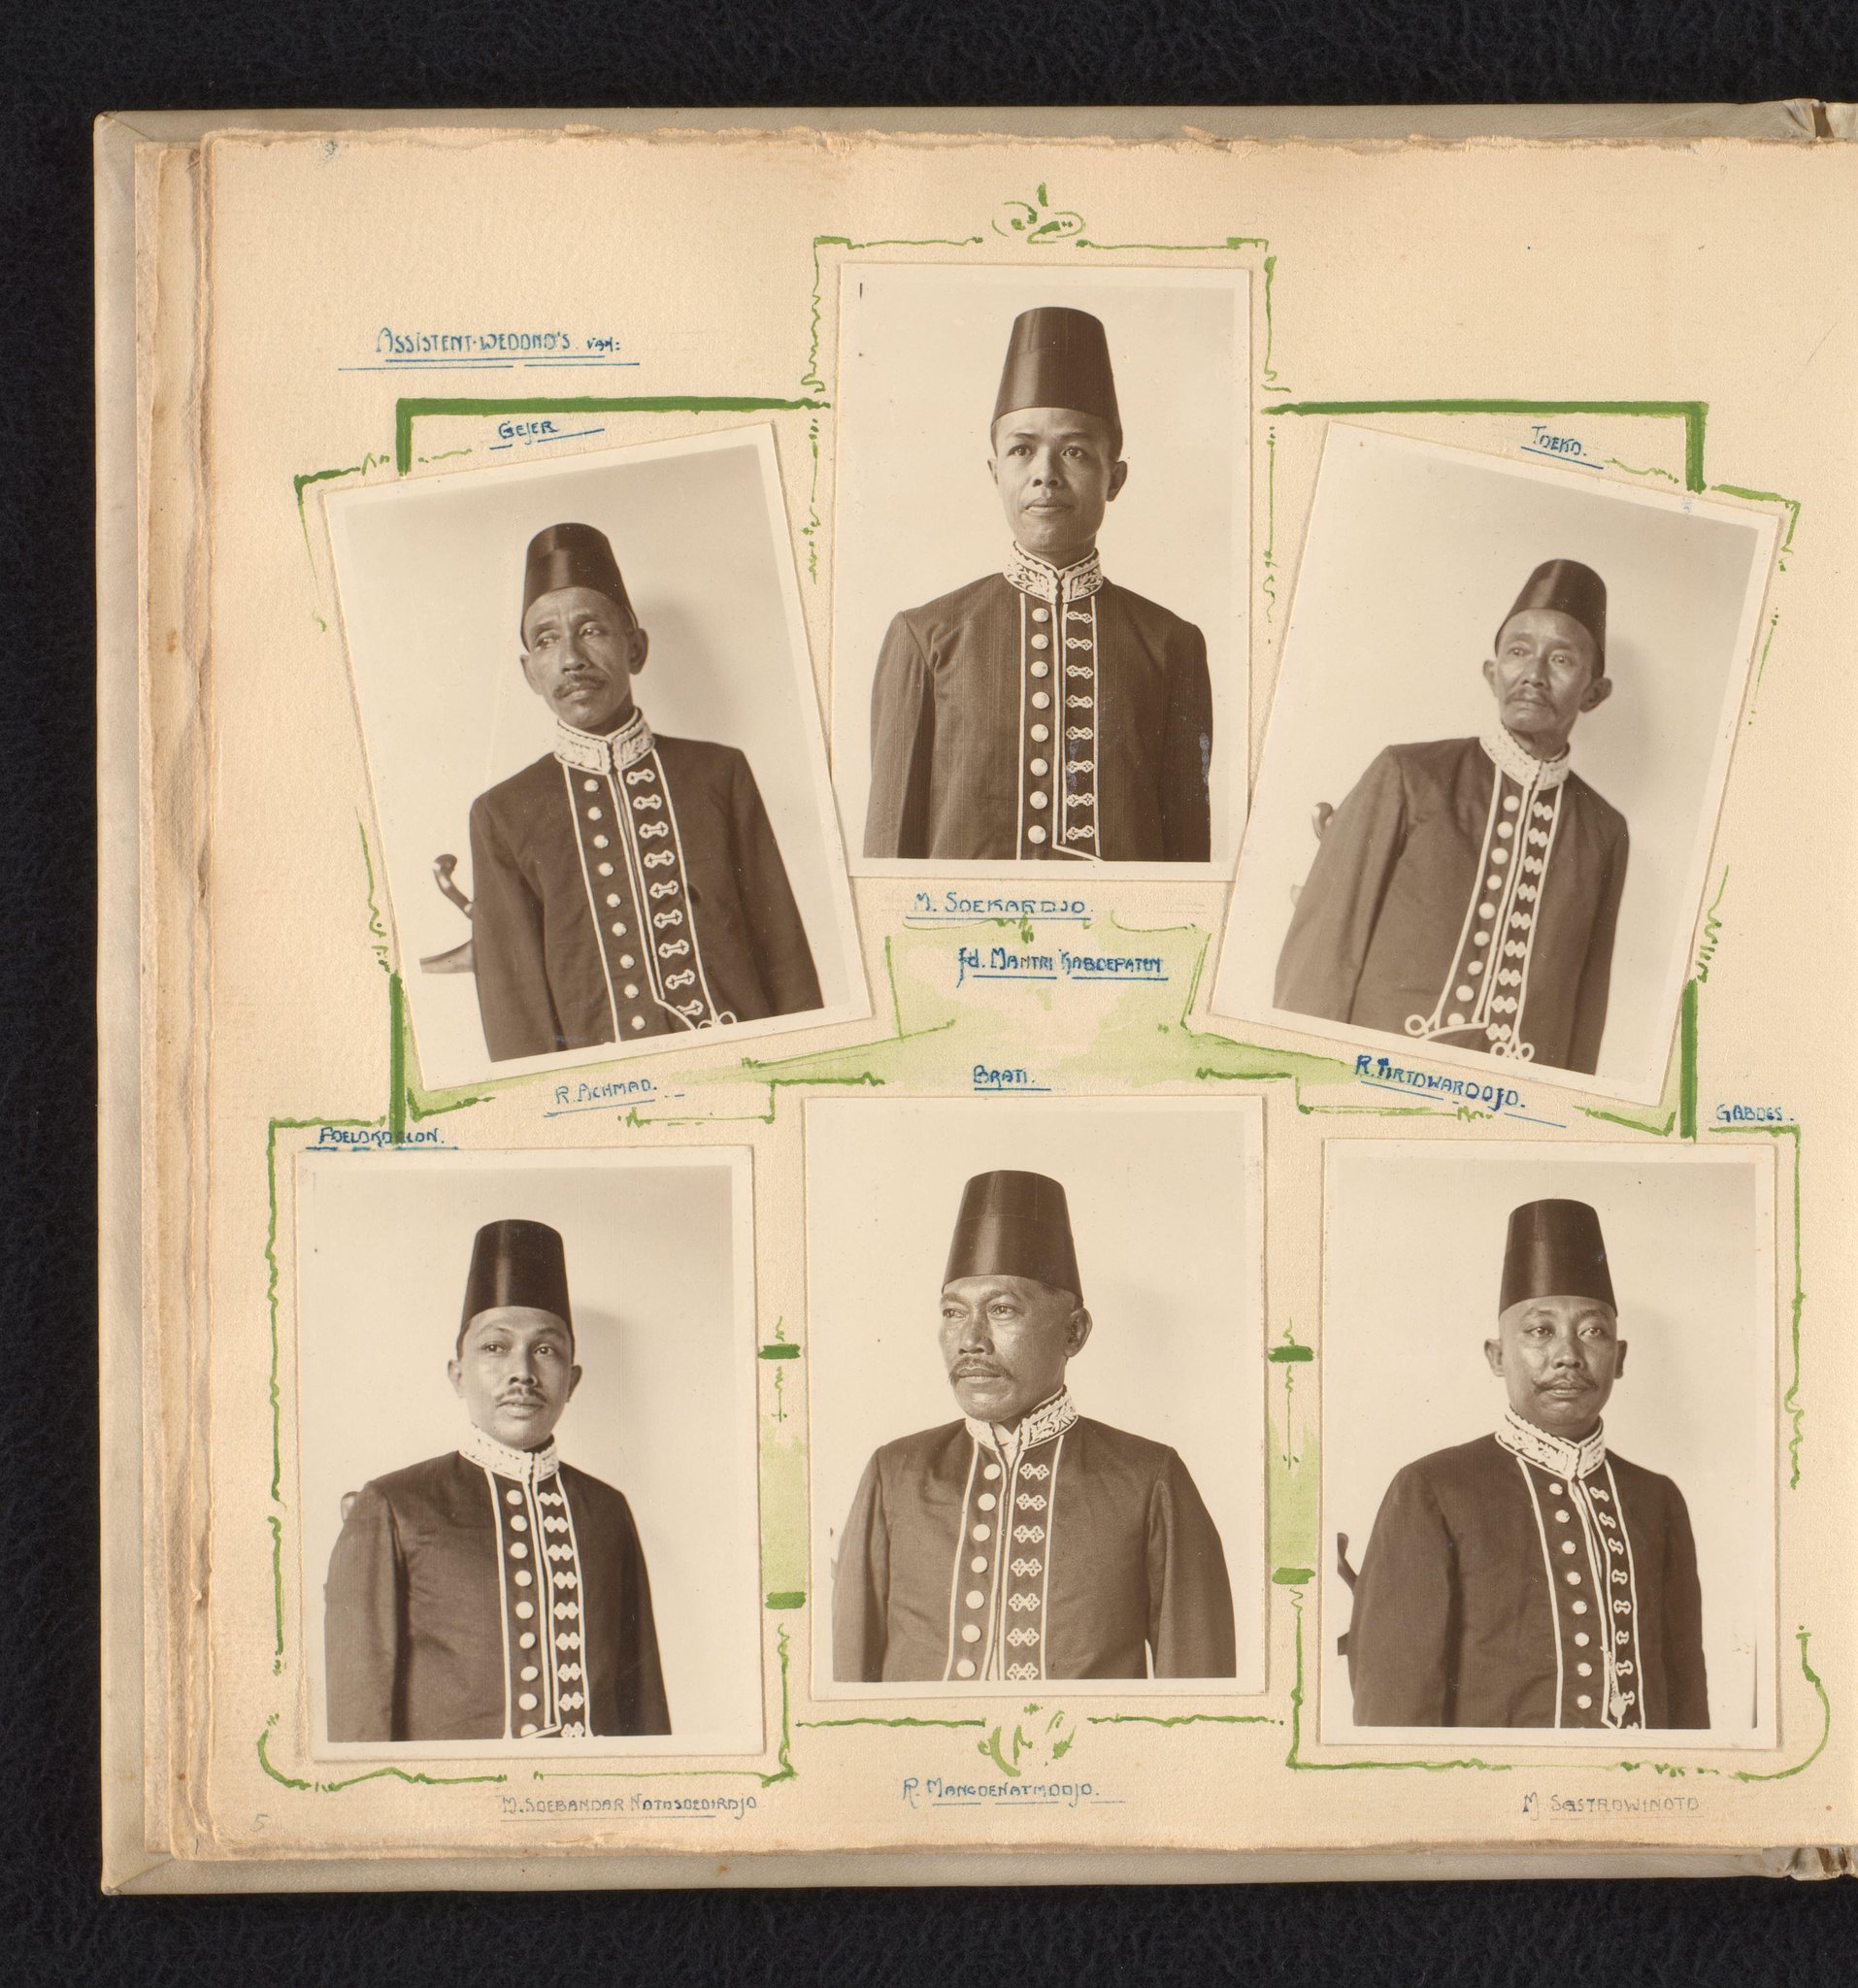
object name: album leaf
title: Assistent-Wedono's van Grobogan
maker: Anonymous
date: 1910-1928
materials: paper, photographic support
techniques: drawing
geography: grobogan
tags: provincial government, official; civil servant; functionary (in general), historical persons, colonial government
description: Albumblad met zes foto's van Javaanse assistent-wedono's (gouvernementsambtenaren) van Grobogan. Het blad is versierd met randwerk om de foto's. Onderdeel van het fotoalbum aangeboden aan J. Habbema door het Binnenlandsch Bestuur Corps van het Regentschap Grobogan, bij het beëindigen van zijn bestuur over het Regentschap, waarschijnlijk in 1928.